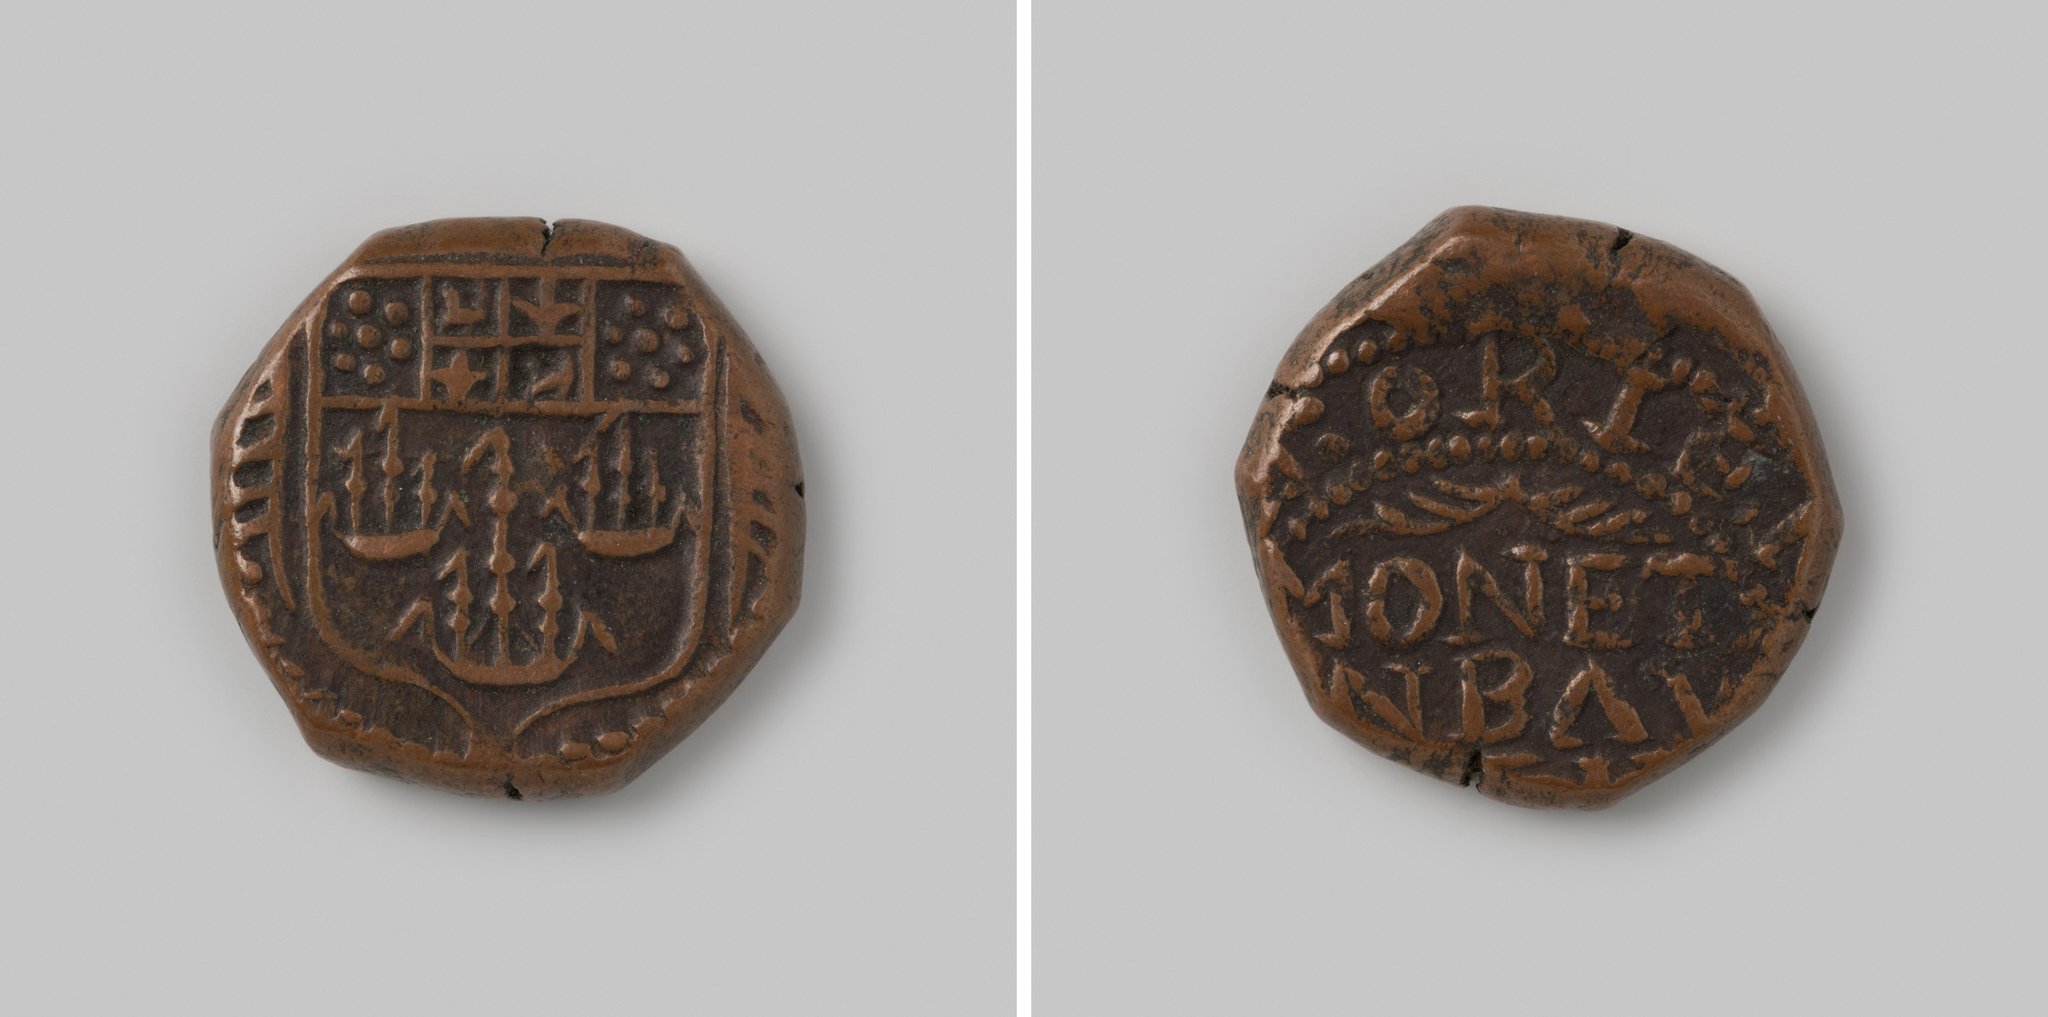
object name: coin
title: Pice uit Bombay in India van de Engelse Oostindische Compagnie (EIC) tijdens Karel II, 1660-1684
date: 1669-1684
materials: copper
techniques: striking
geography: mumbai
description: Koperen munt. Voorzijde: binnen versiering wapenschild van de EIC. Keerzijde: binnen versiering in twee regels aanduiding van de muntplaats: Bombay